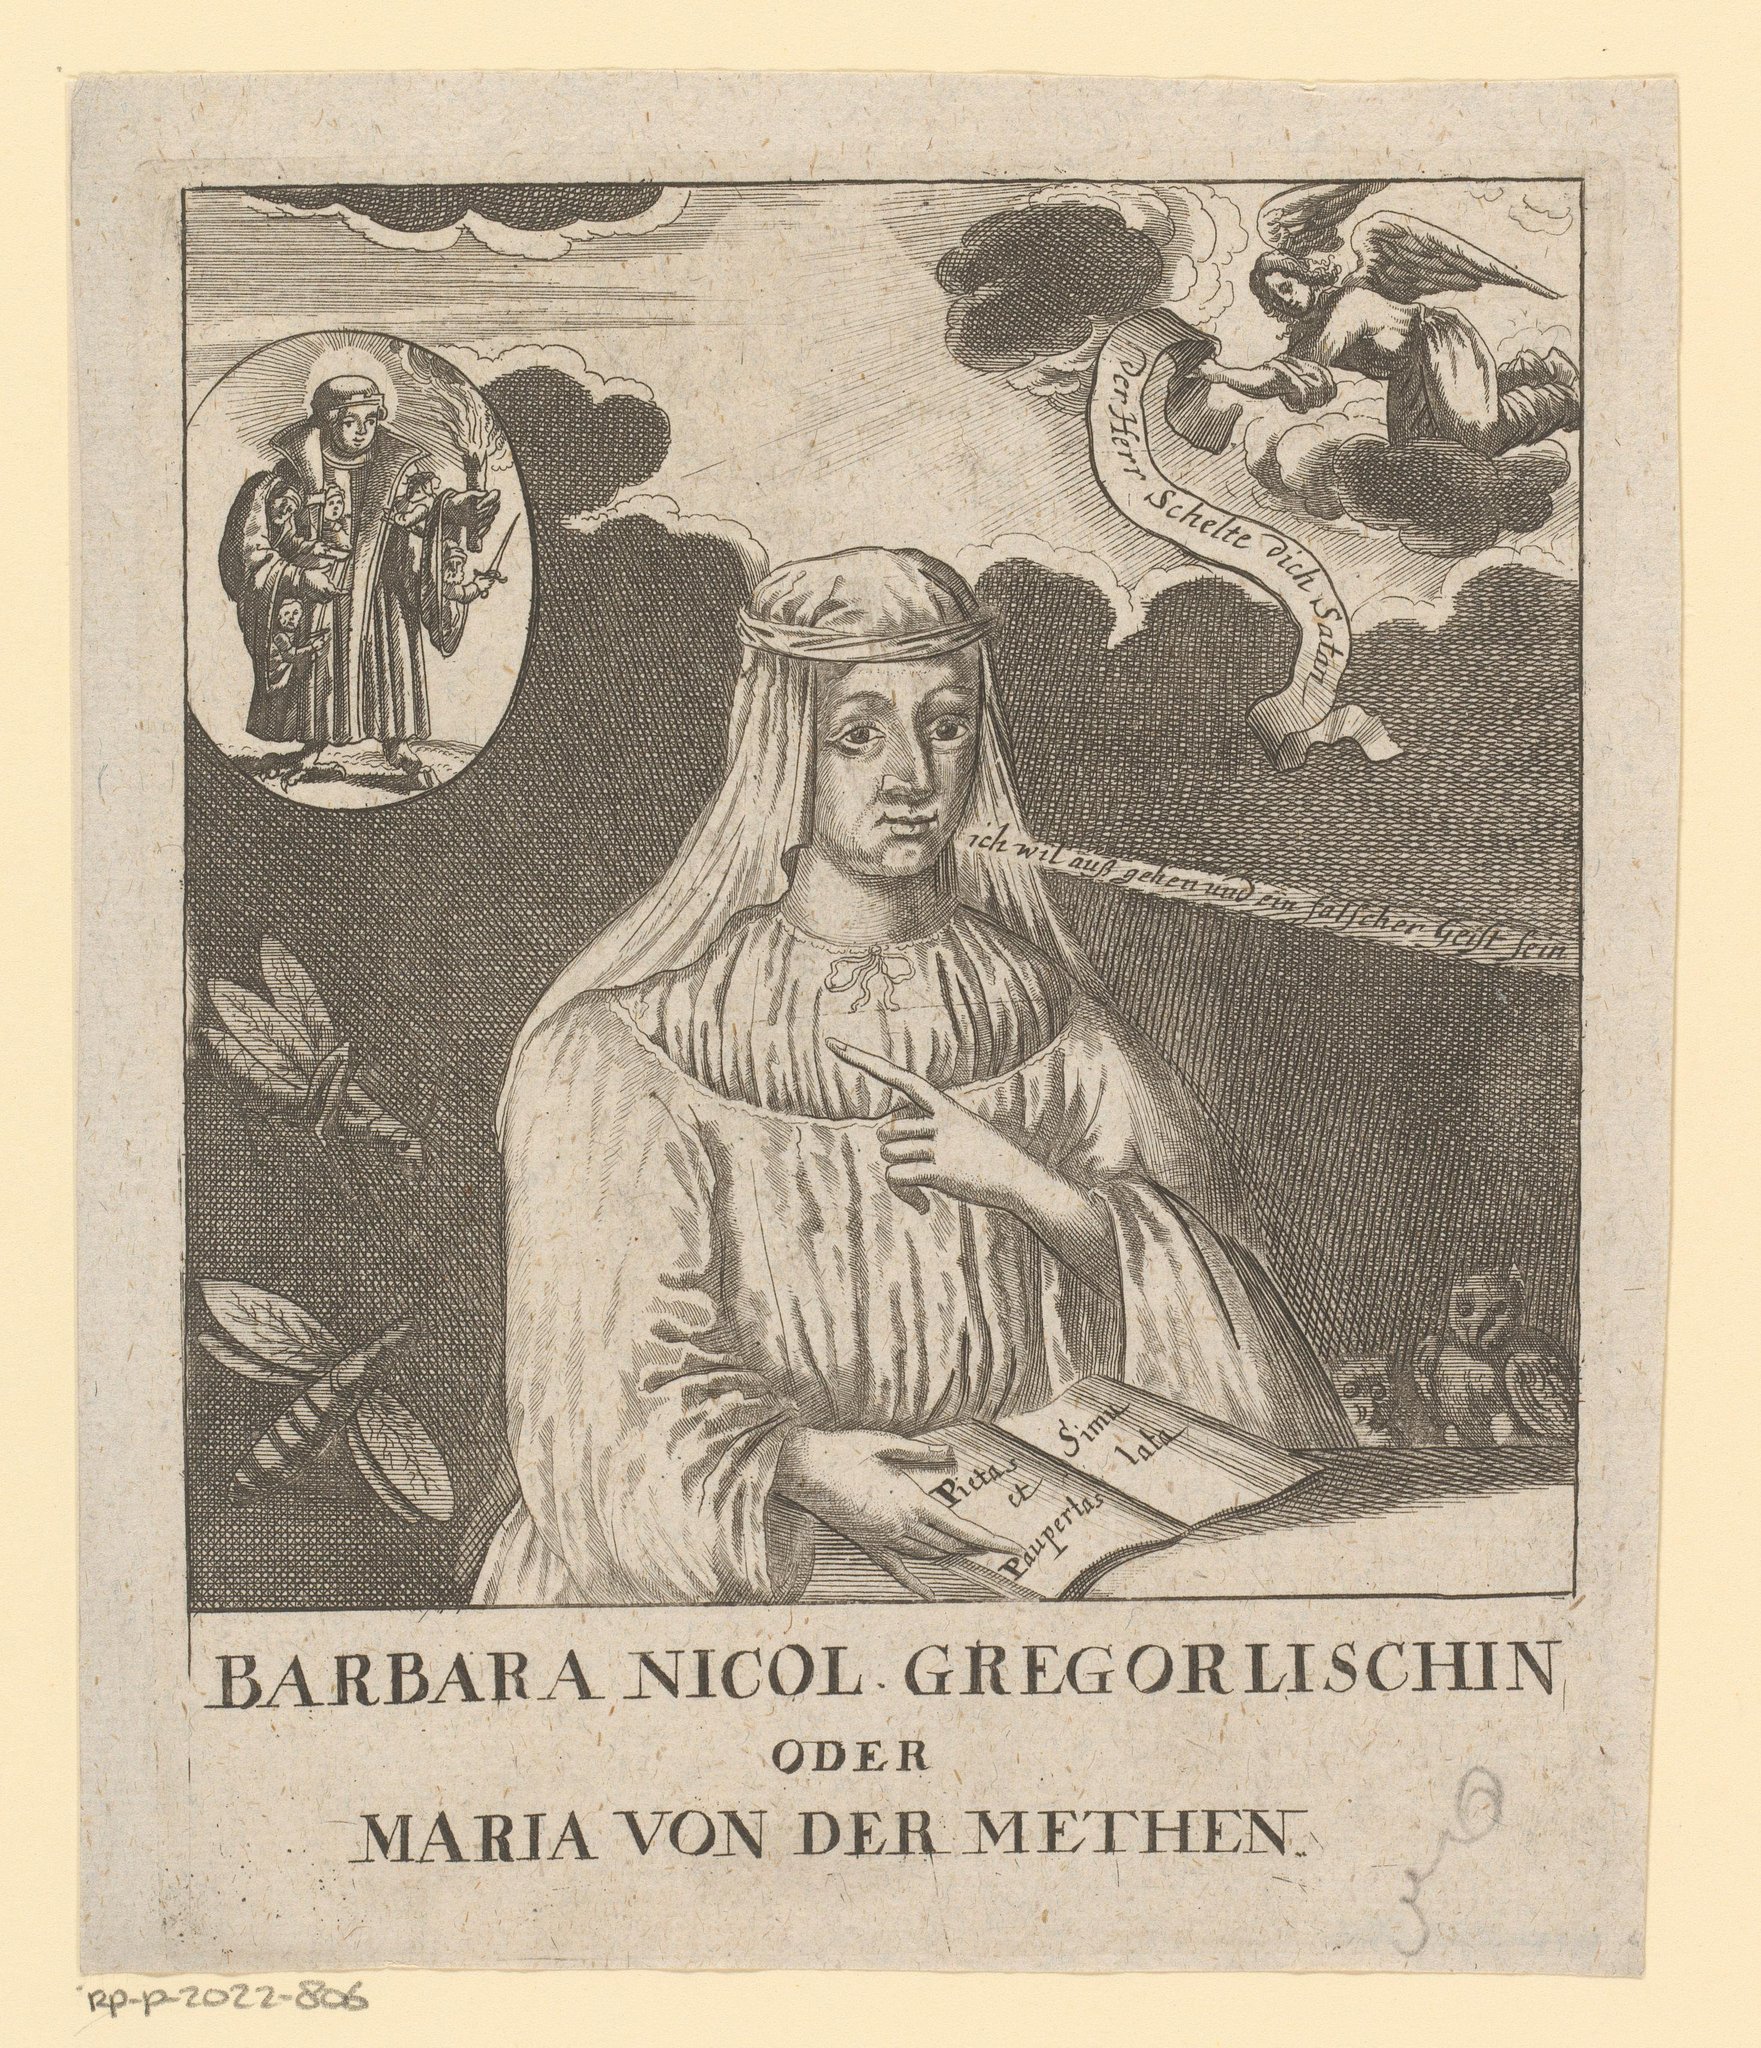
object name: print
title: Barbara Nicol. Gregorilischin oder Maria von der Methen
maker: Anonymous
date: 1600-1700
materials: paper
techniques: engraving, etching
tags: historical persons - bb - woman